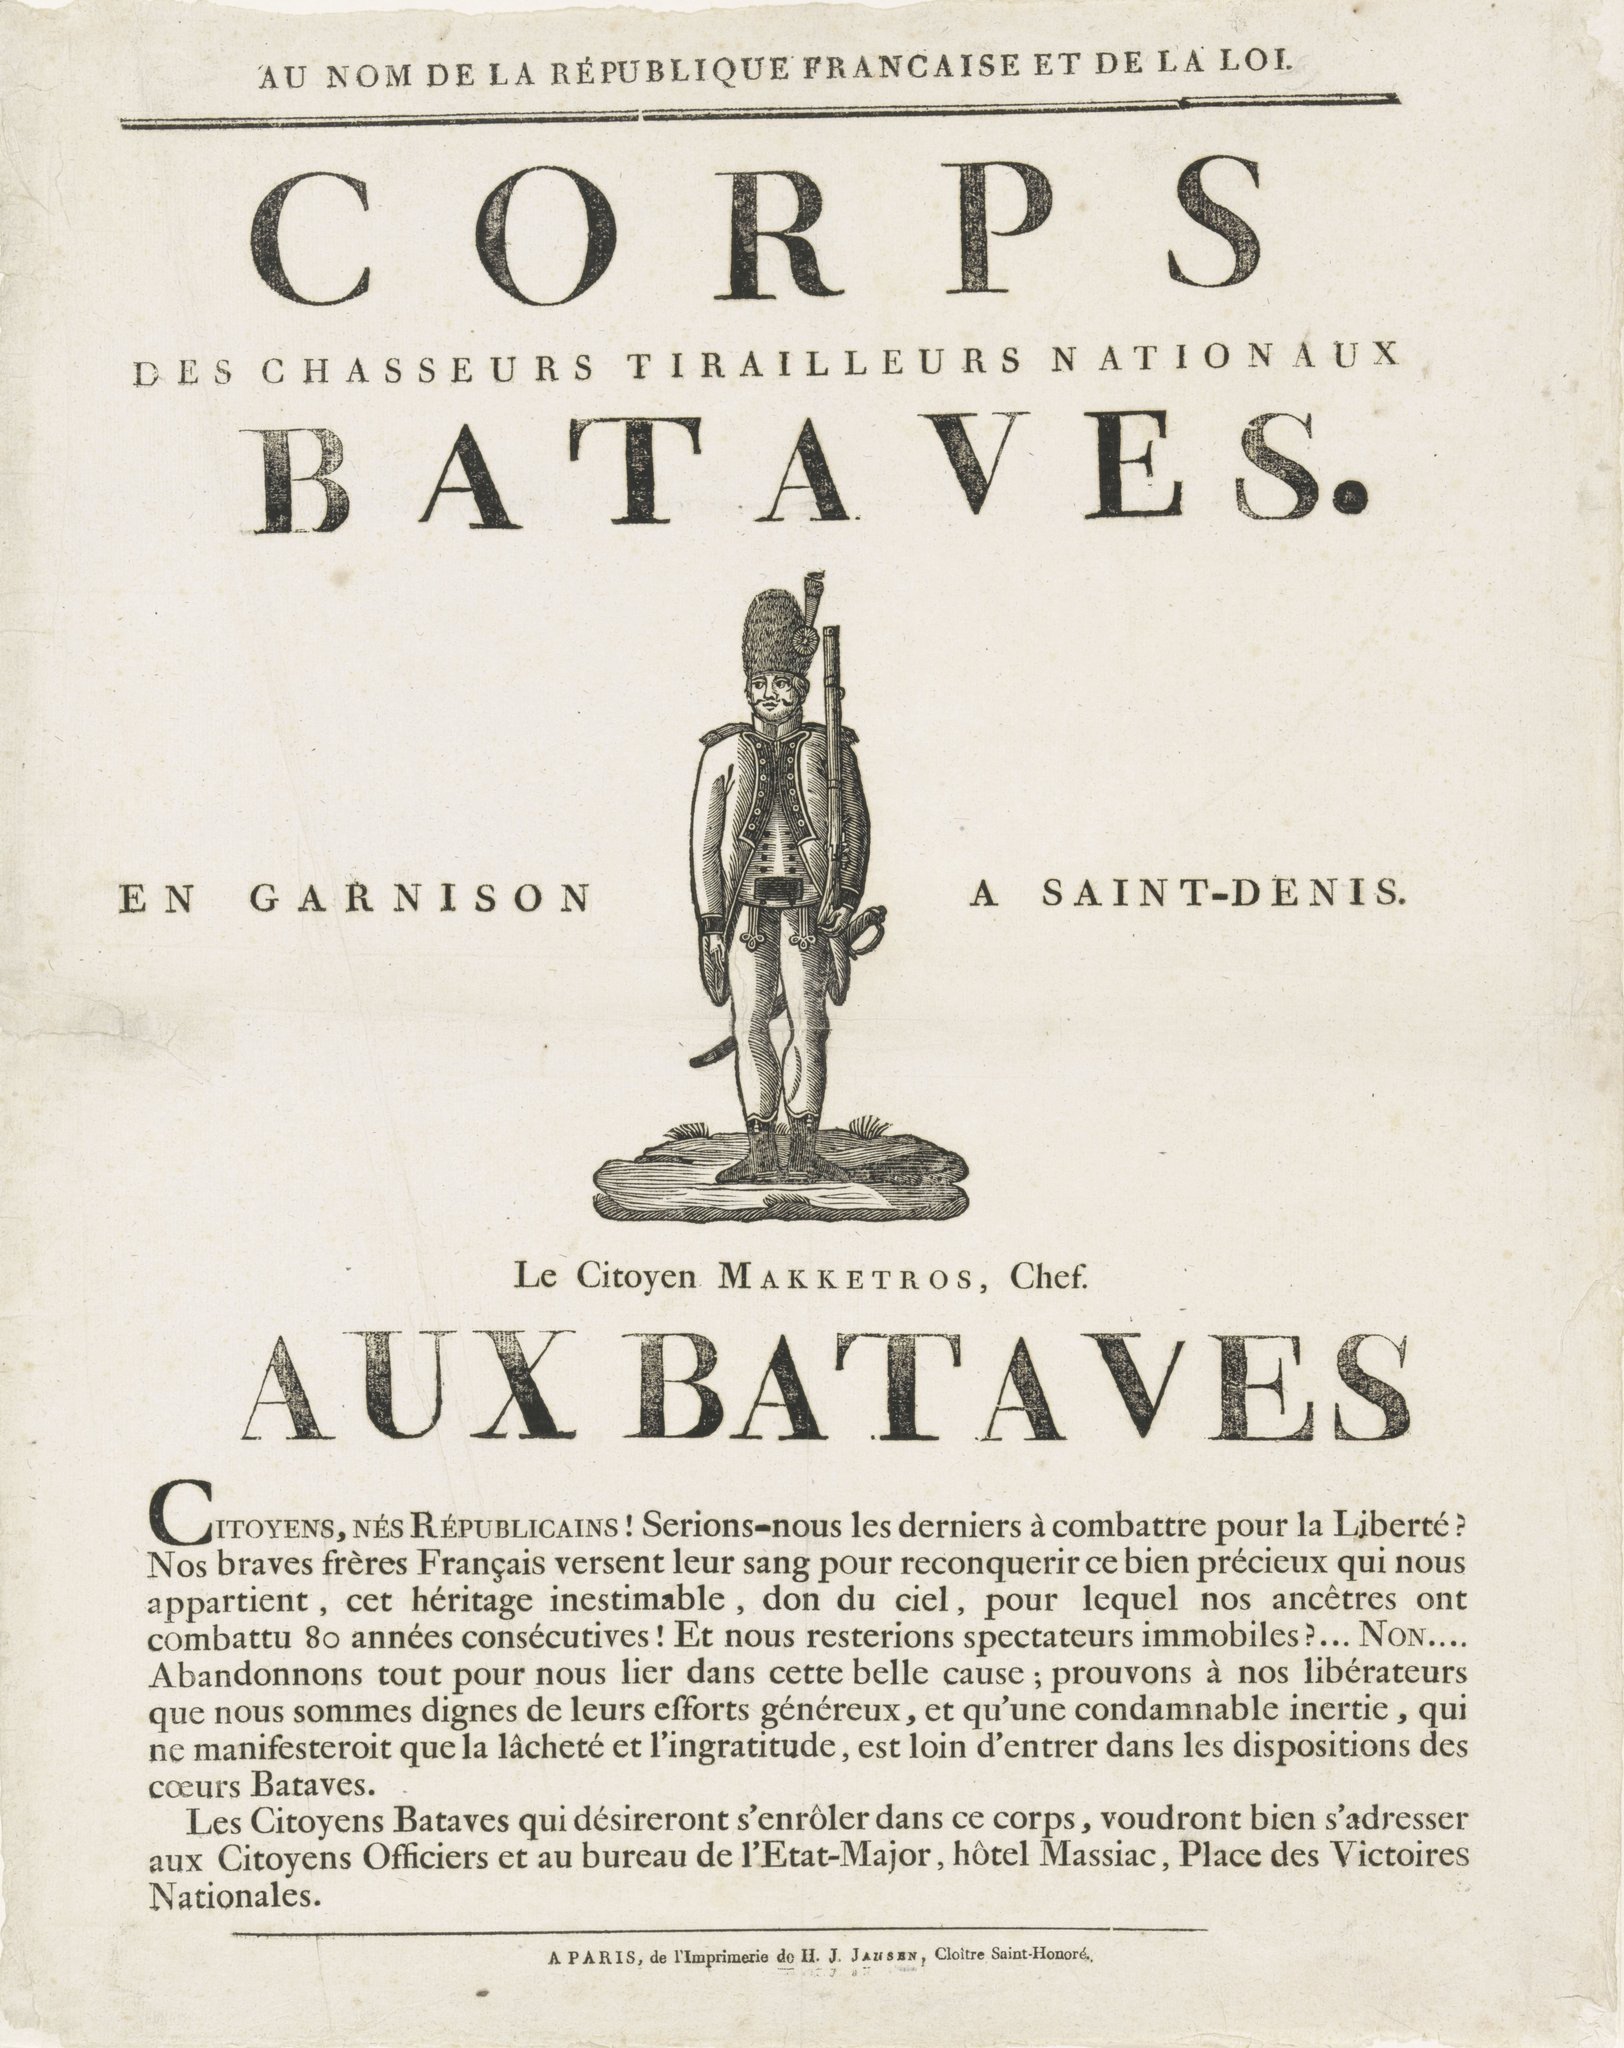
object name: print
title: Corps des Chasseurs Tirailleurs Nationaux Bataves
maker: hendrik .j. jansen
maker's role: printer, publisher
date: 1793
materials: paper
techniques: letterpress printing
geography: paris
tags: paris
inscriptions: collector's mark: Lugt 2228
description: Frans biljet met een oproep aan de Hollandse uitgewekenen (patriotten) in Frankrijk om zich aan te sluiten bij het Bataafs Legioen (Corps Bataves) en samen te vechten met hun Franse broeders. Centraal een staande militair. Waarschijnlijk van rond november 1793.